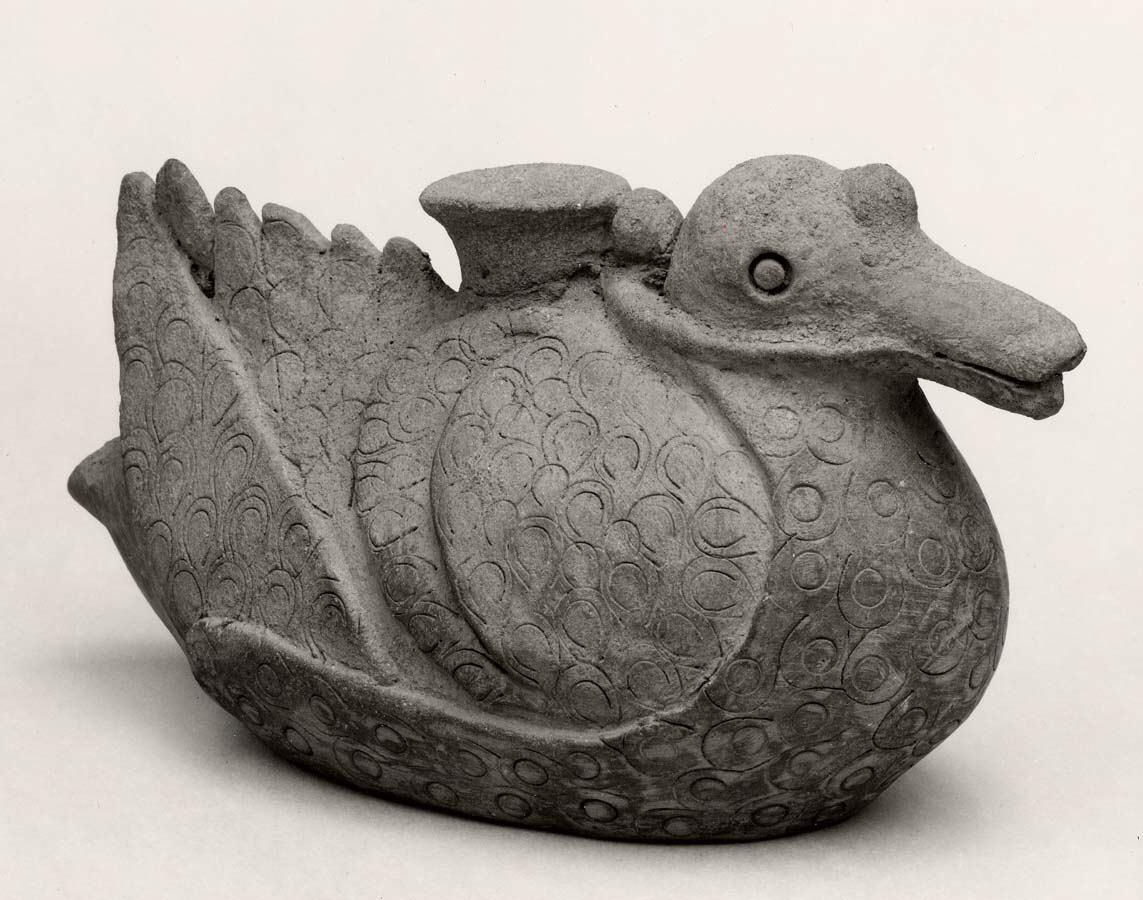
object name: vessel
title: Bird-shaped vessel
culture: korean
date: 676-1392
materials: stoneware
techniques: stamping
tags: ducks